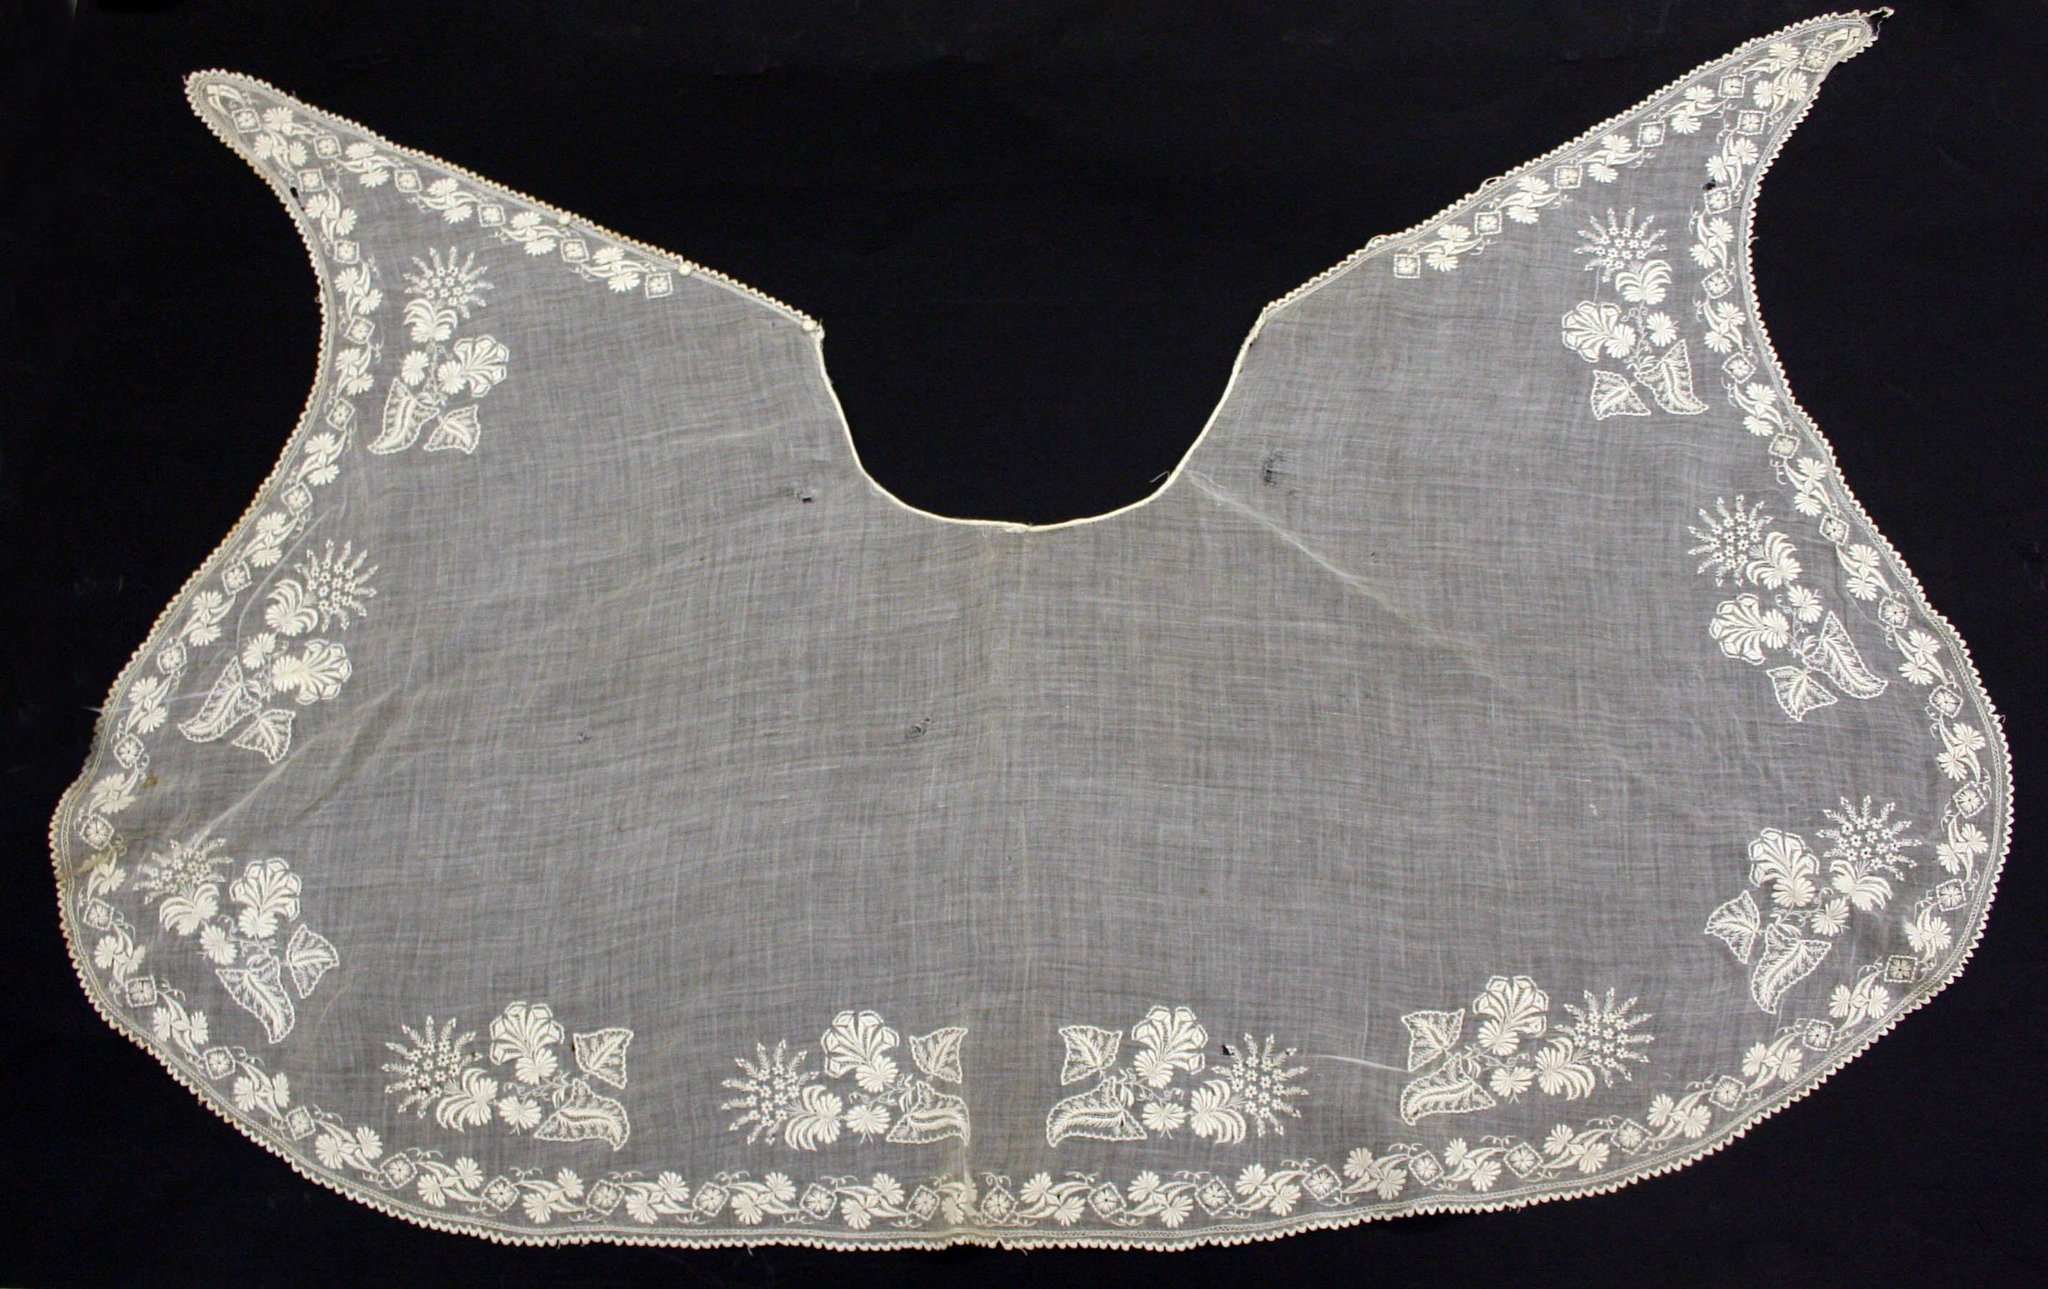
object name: collar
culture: american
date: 1840-1849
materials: cotton